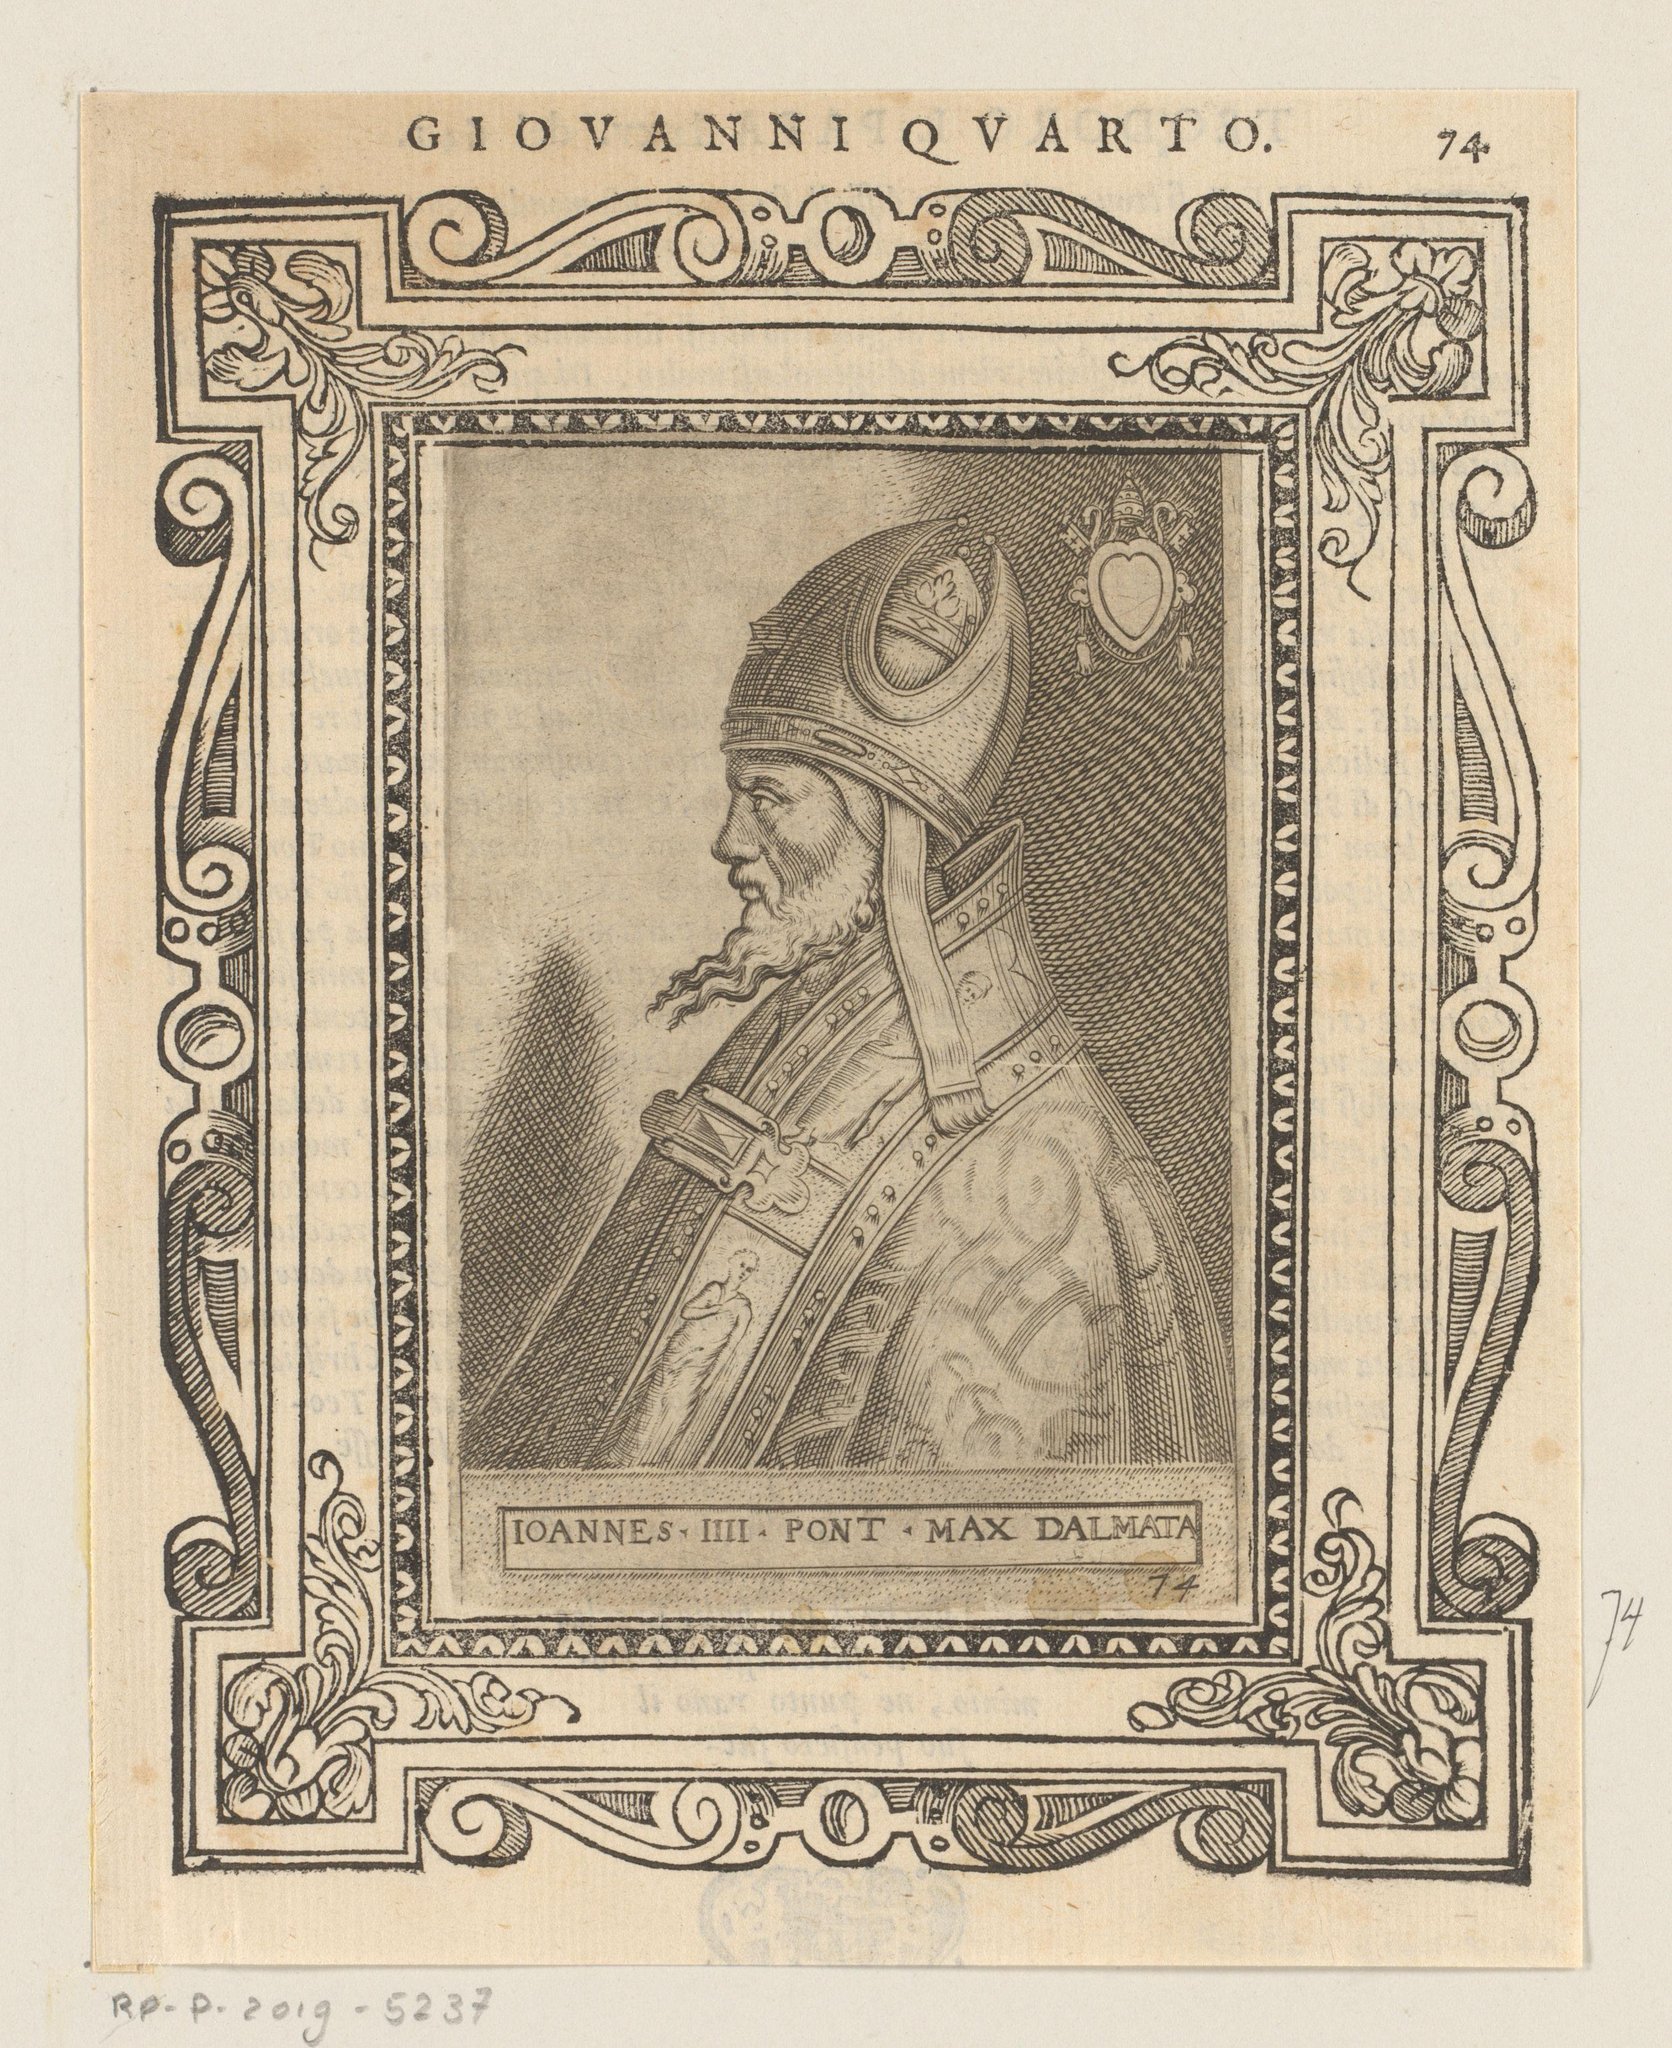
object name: book illustration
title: Portret van paus Johannes IV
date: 1587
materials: paper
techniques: engraving, letterpress printing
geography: rome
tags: historical persons, pope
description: Prent uit: Ciccarelli, Antonio. Le vite de Pontefici di Antonio Ciccarelli (...). Rome: Domenico Basa, 1587. Prent voor het eerst verschenen in: Cavalieri, Giovanni Battista de'. Pontificum romanorum effigies (...). Rome: Domenico Basa en Francesco Zanetti, 1580. Prent ook gebruikt in latere publicaties.